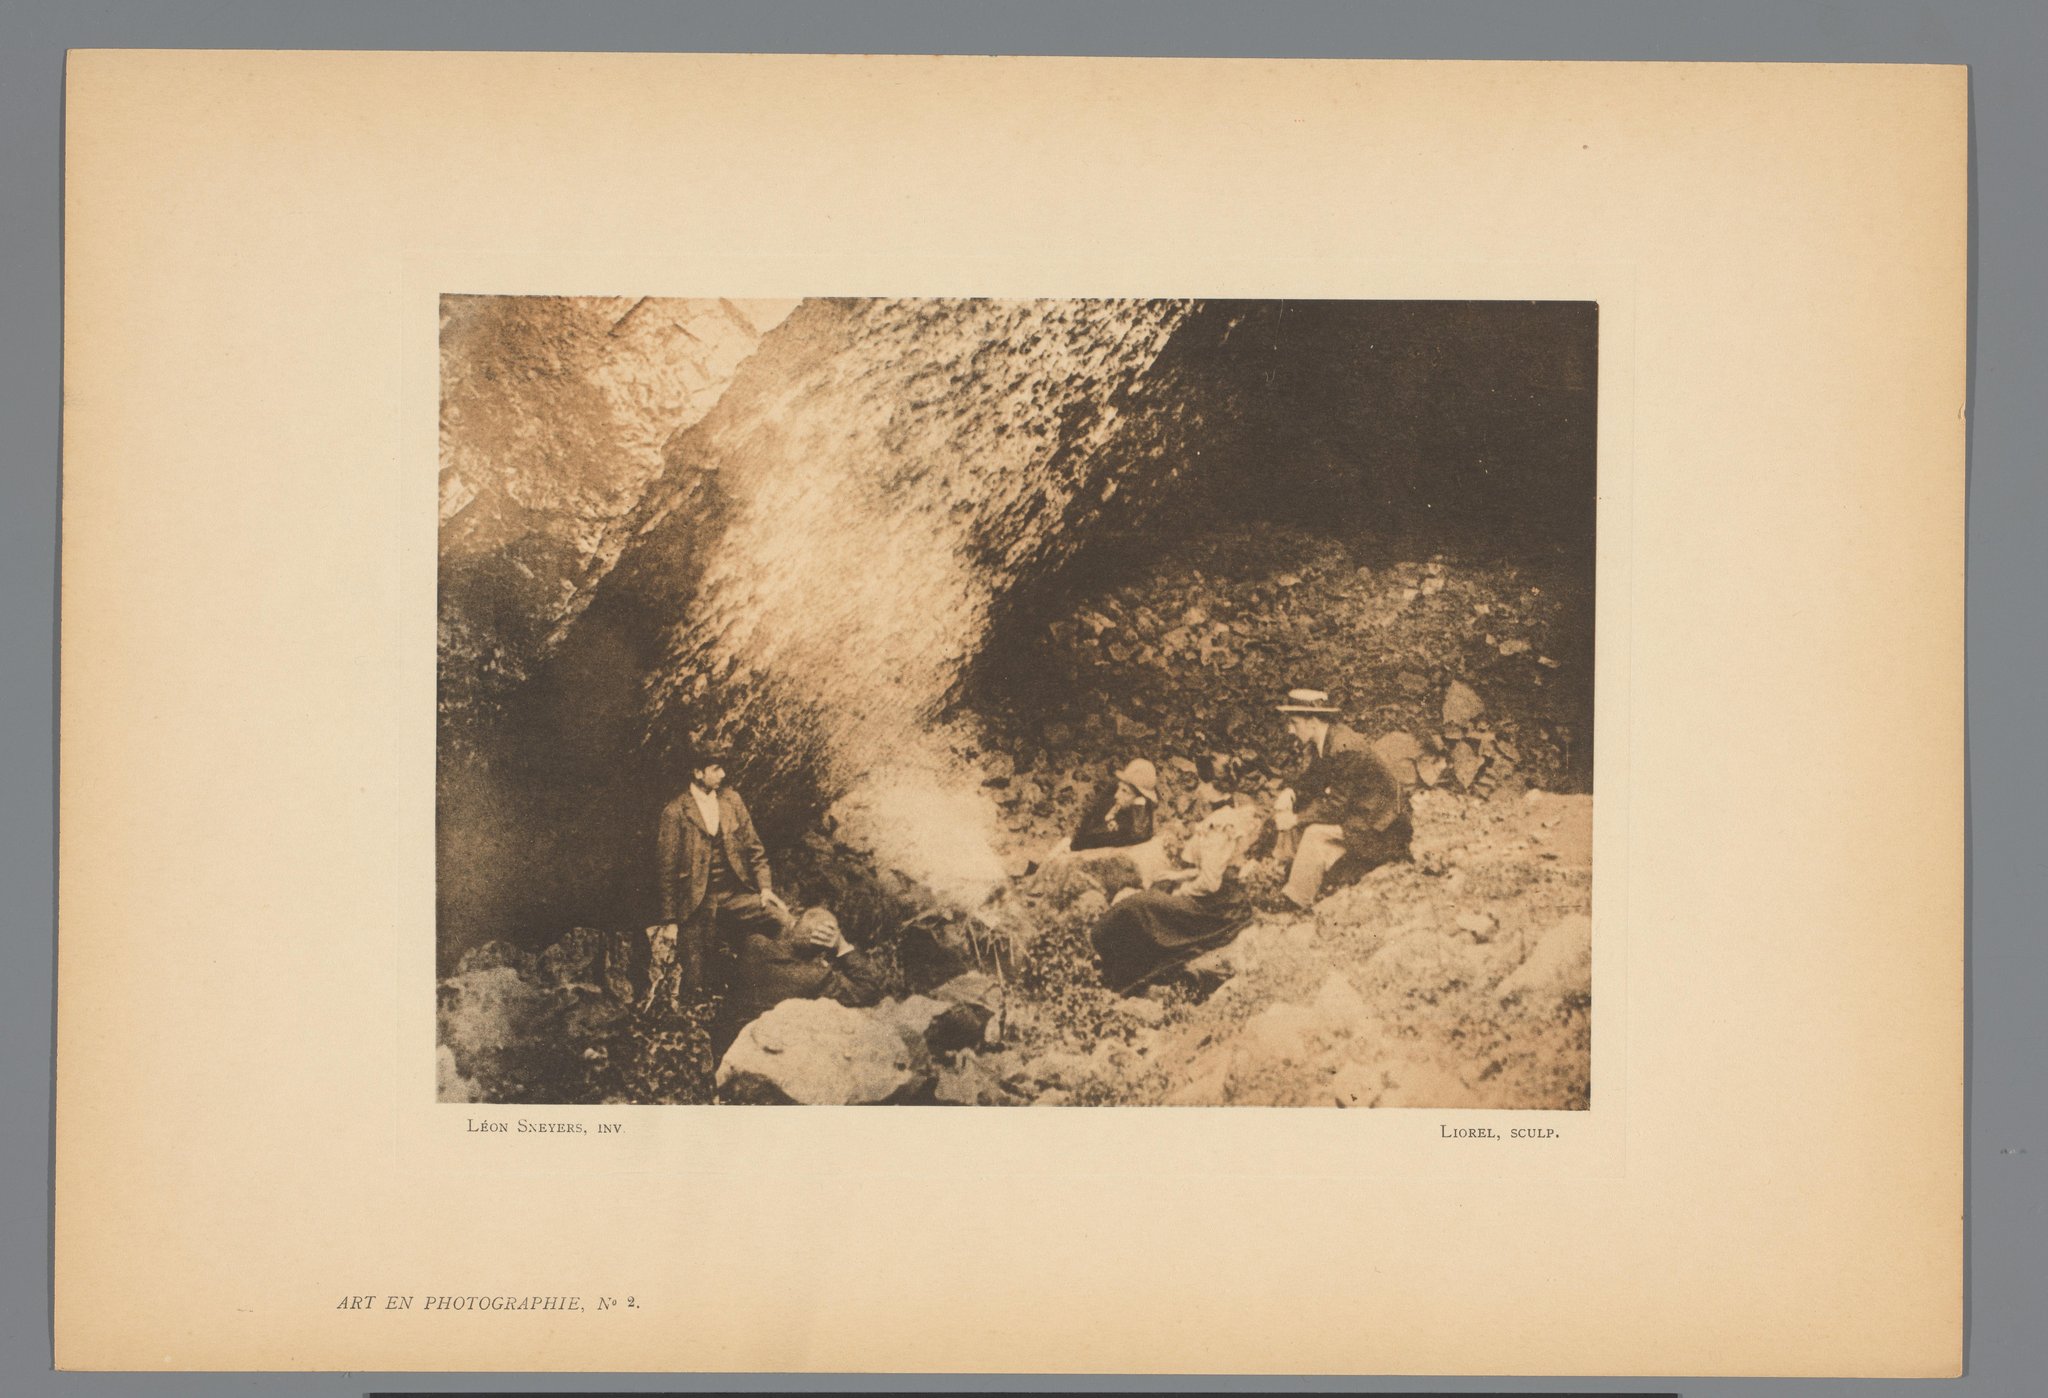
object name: photomechanical print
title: Vier mannen en een vrouw zitten bij een rotswand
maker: léon sneyers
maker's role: architect, fotograaf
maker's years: 1877-1949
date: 1896-1901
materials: paper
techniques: photograph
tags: adult woman, adult man (+ four persons), rock-formations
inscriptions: inscription: ‘ART EN PHOTOGRAPHIE, No 2.’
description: Deze prent maakt deel uit van een omslag met 54 prenten op 52 bladen.